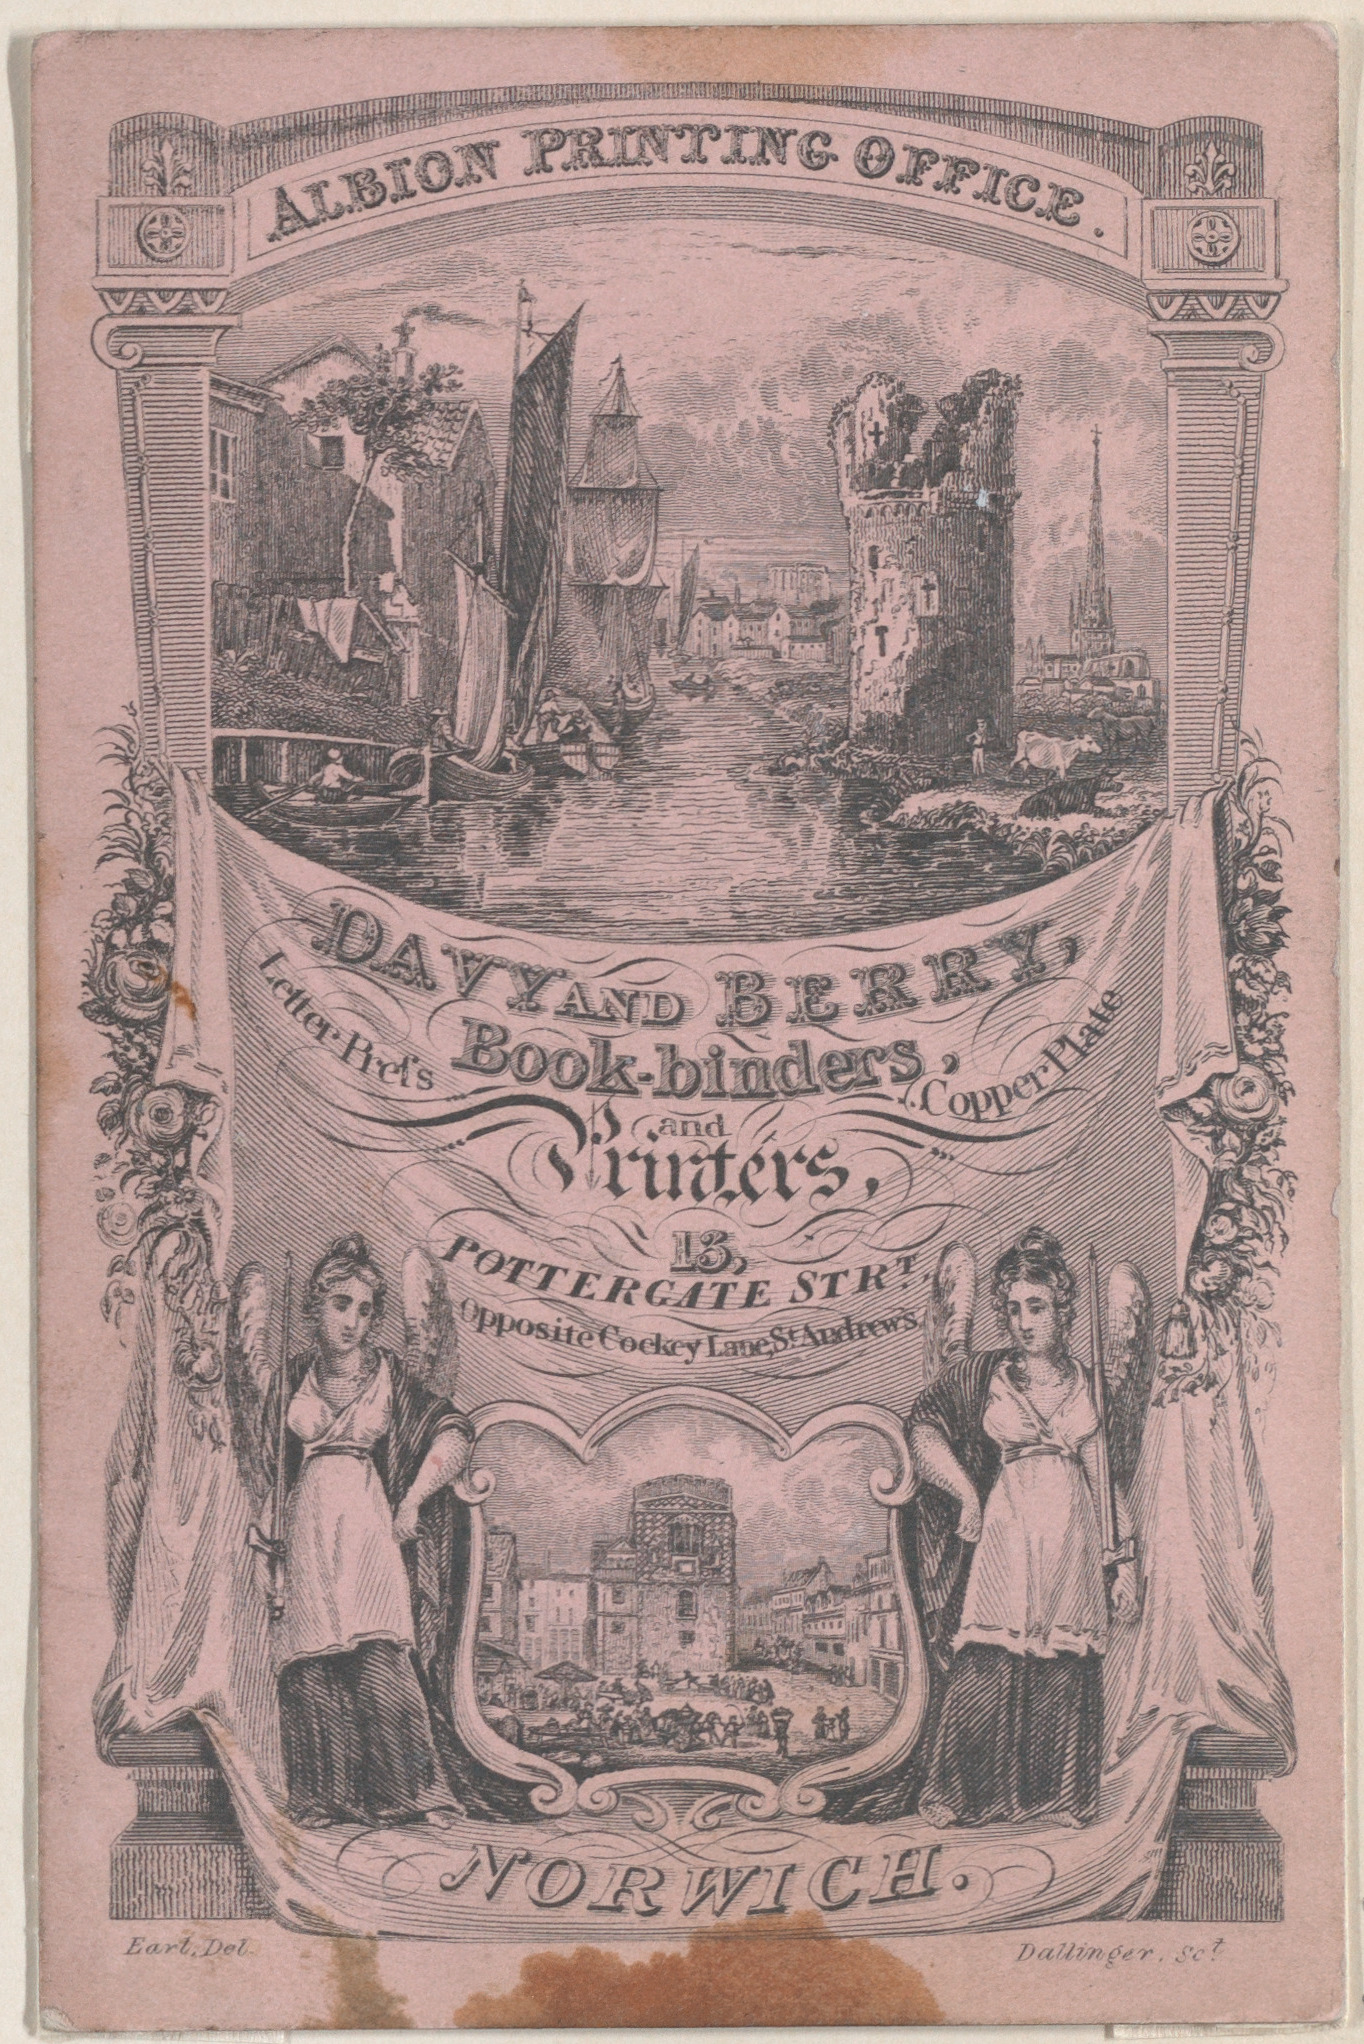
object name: print, trade card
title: Trade card for Davy and Berry, Book-Binder and Printer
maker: joseph stephen dallinger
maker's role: artist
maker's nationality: british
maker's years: 1808-1875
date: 1801-1900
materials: paper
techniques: engraving